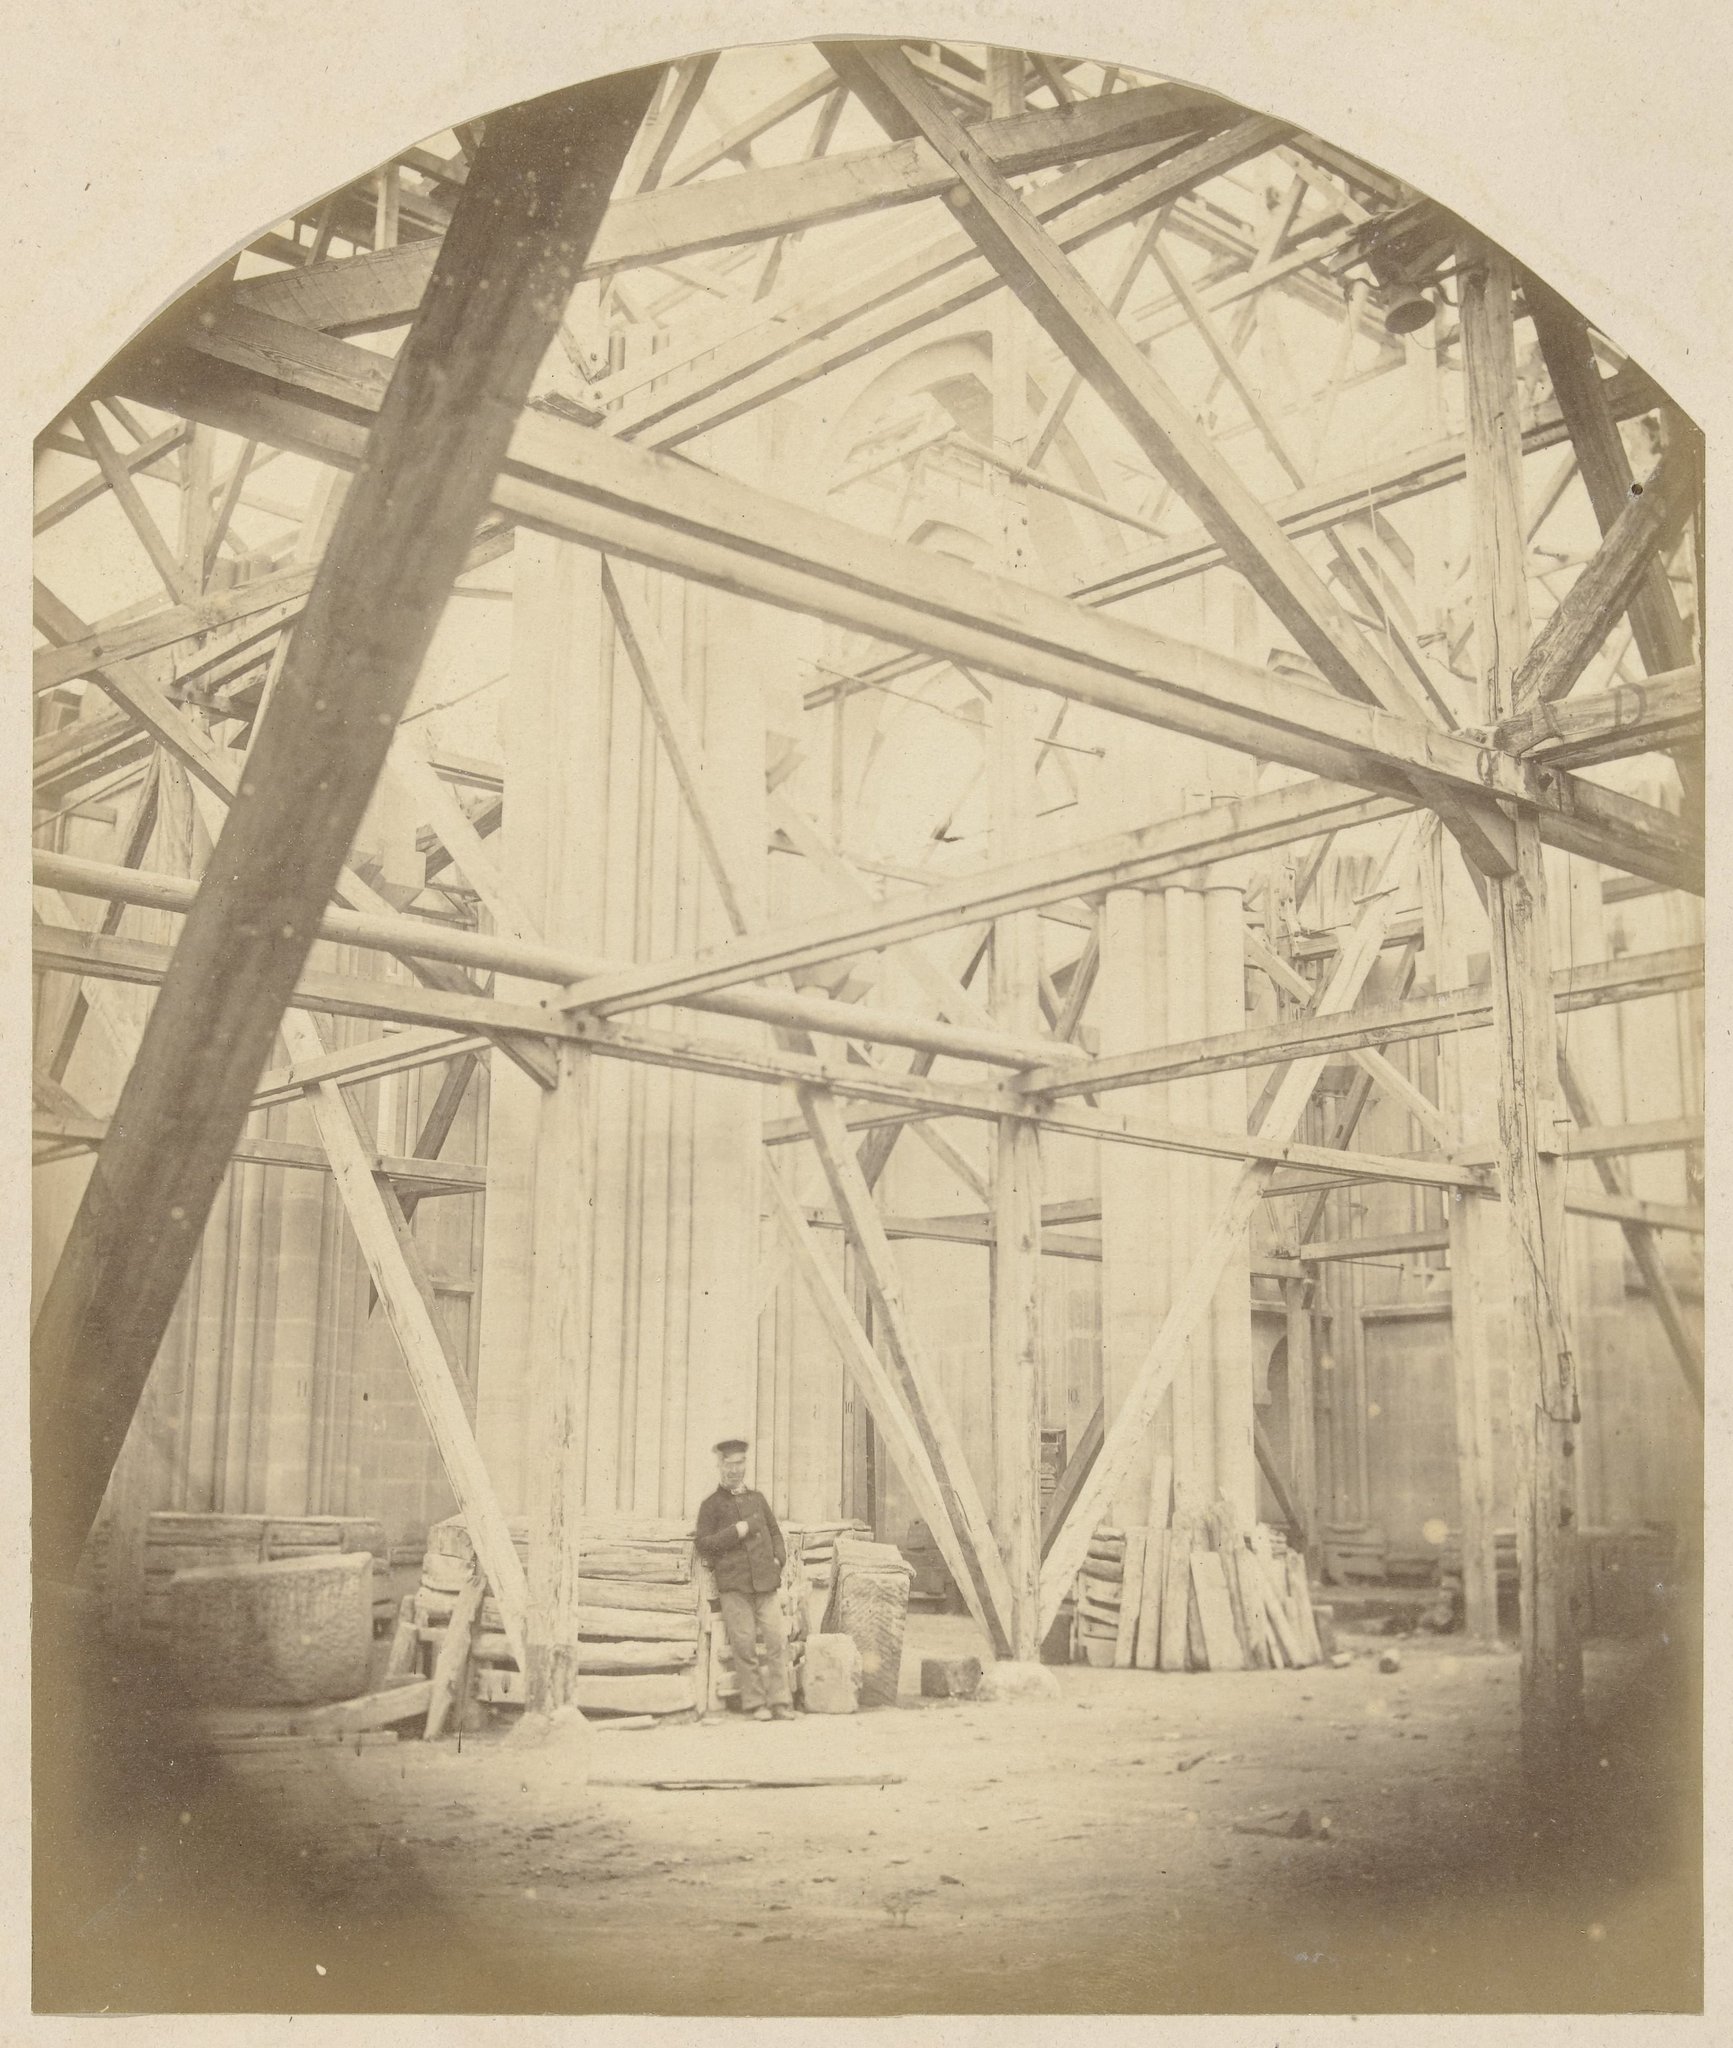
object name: photograph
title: Église Saint-Vincent-de-Paul te Marseille in aanbouw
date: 1855-1860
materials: cardboard, paper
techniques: albumen print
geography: marseille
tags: building-site, marseille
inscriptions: inscription: ‘No. 4 Angle du Transept Côté Nord’